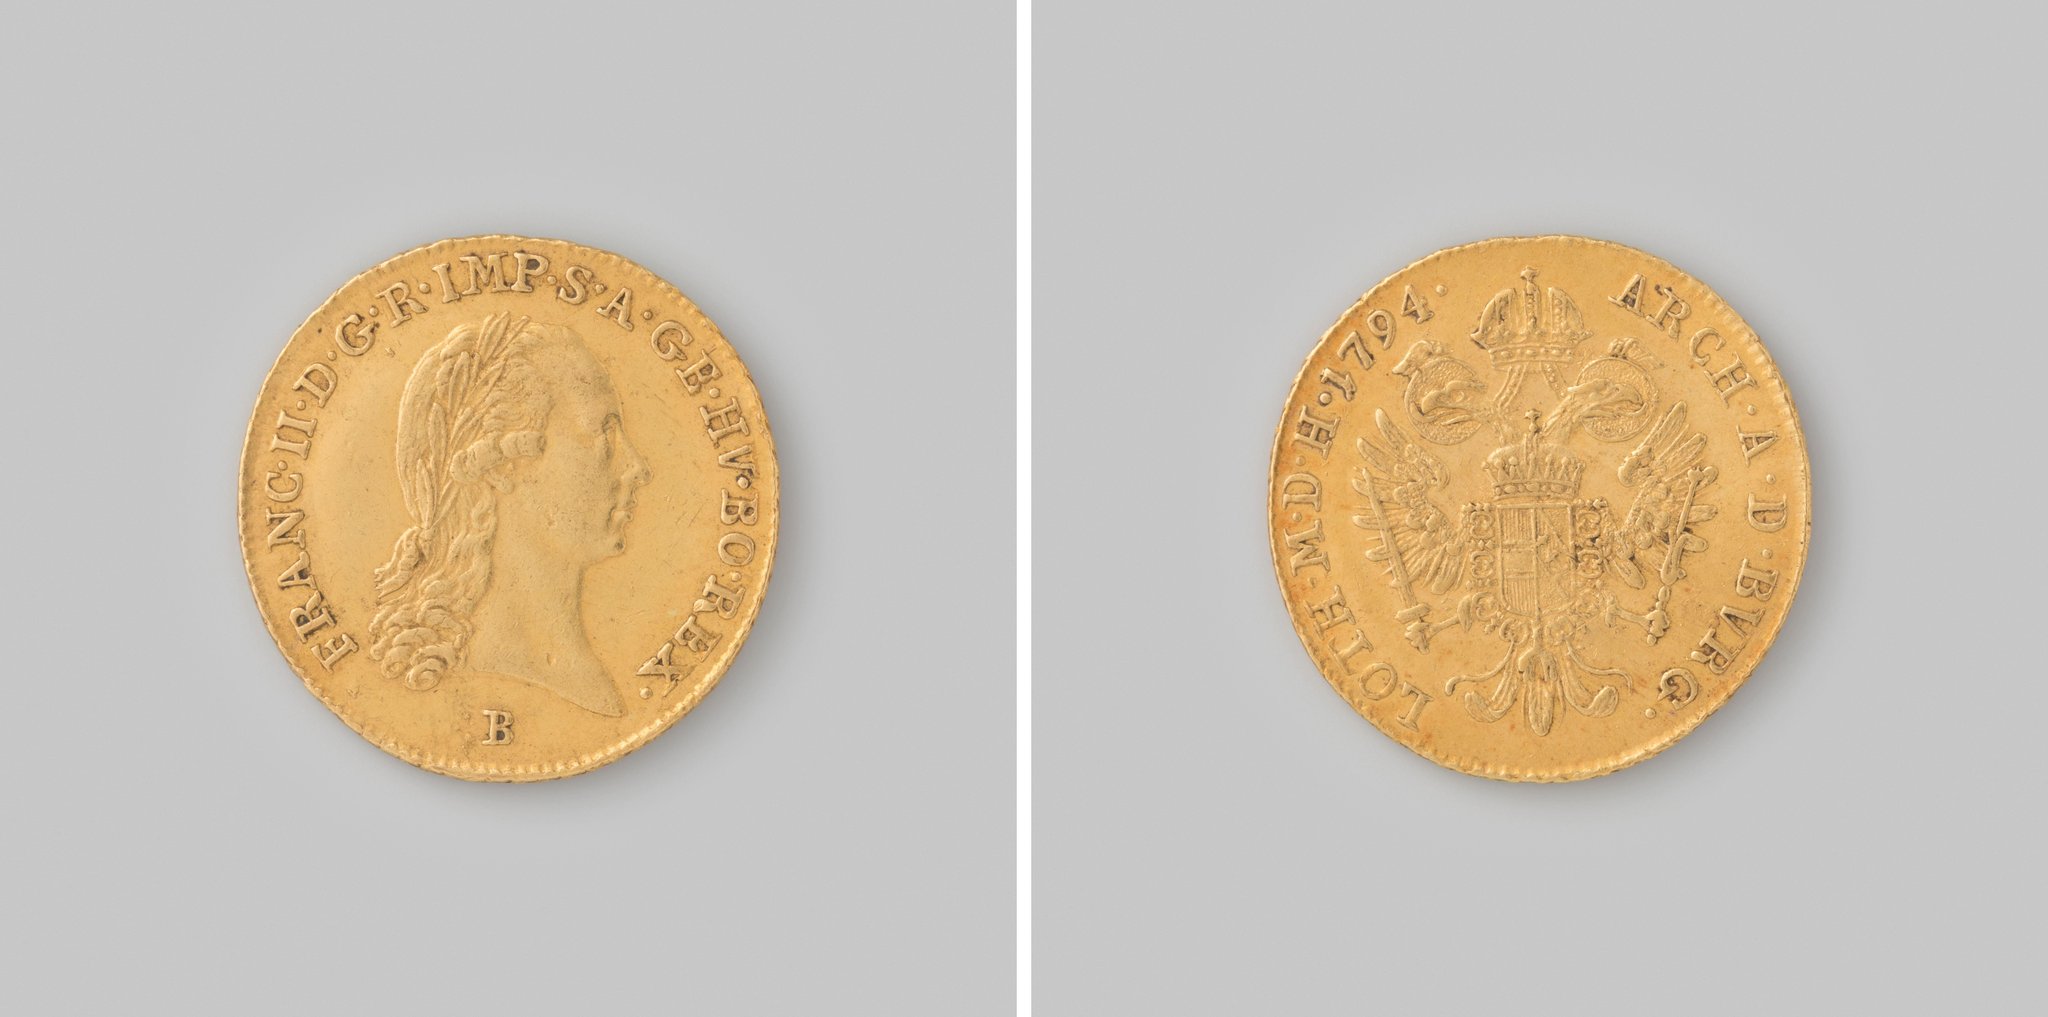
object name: coin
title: Dukaat uit Oostenrijk van keizer Franz II, 1794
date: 1794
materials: gold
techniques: striking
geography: kremnica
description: Gouden munt. Voorzijde: gelauwerd hoofd van de vorst naar rechts. Daaronder letter B [=Kremnitz]. Keerzijde: gekroonde dubbelkoppige adelaar, met op zijn borst een door een ridderorde met juweel omhangen gekroond wapenschild en met in zijn poten zwaard en scepter. Jaartal aan het eind van het omschrift. Kabelrand.